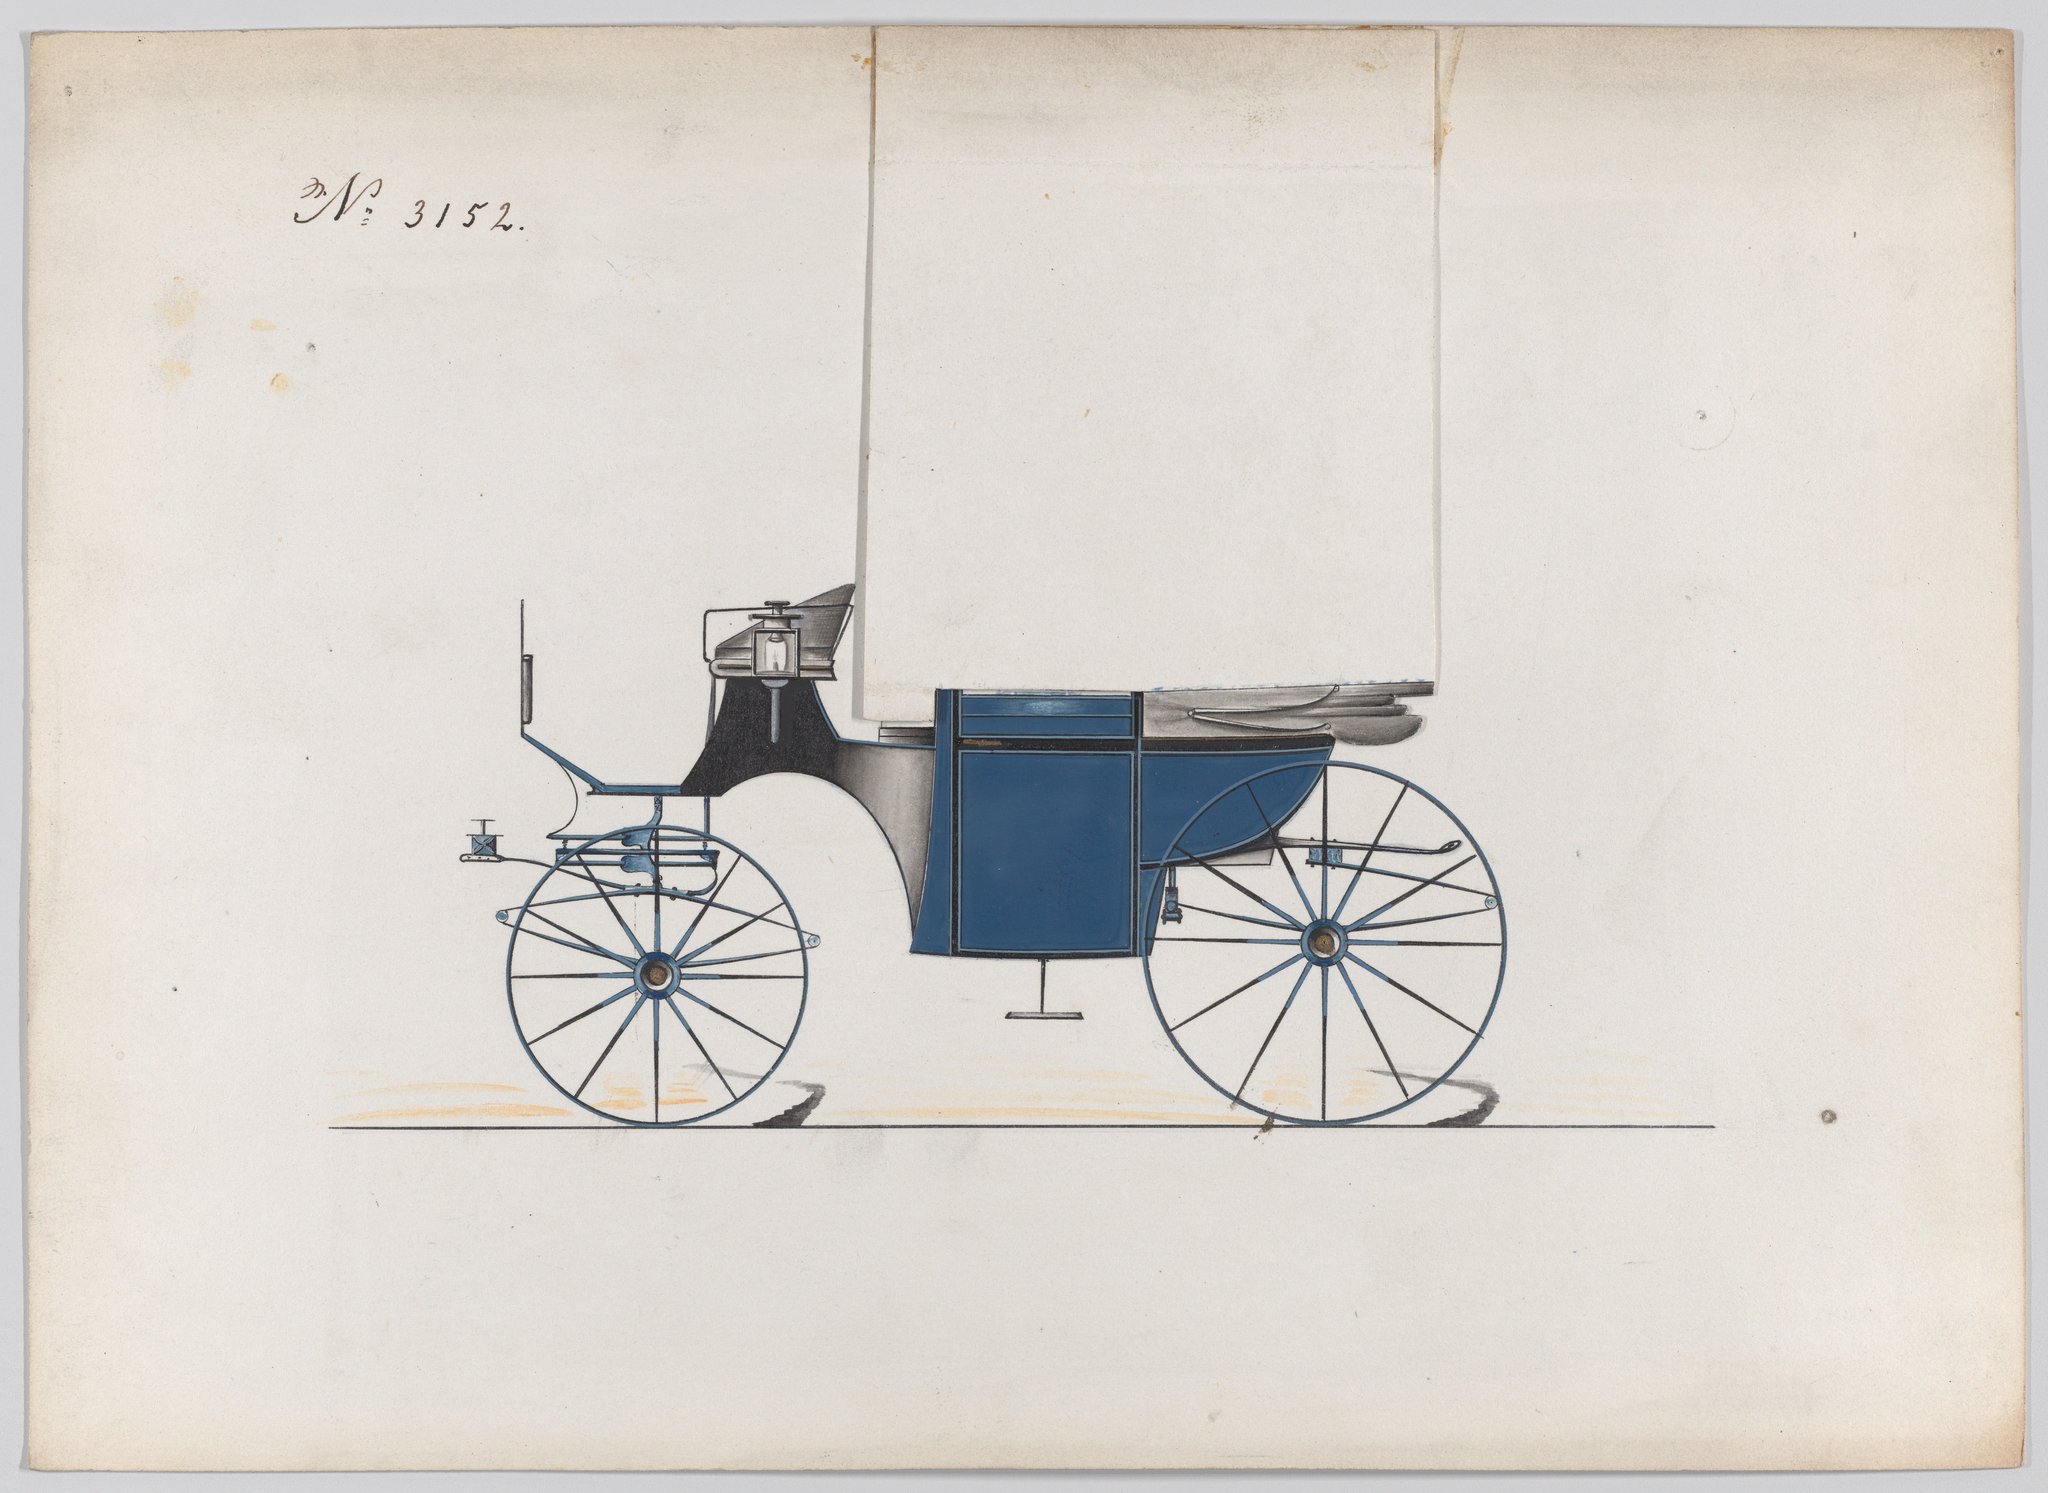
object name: drawing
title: Design for Landaulet, no. 3152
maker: brewster & co.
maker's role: manufacturer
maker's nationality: american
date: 1875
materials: gouache, ink, watercolor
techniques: pen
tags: carriages